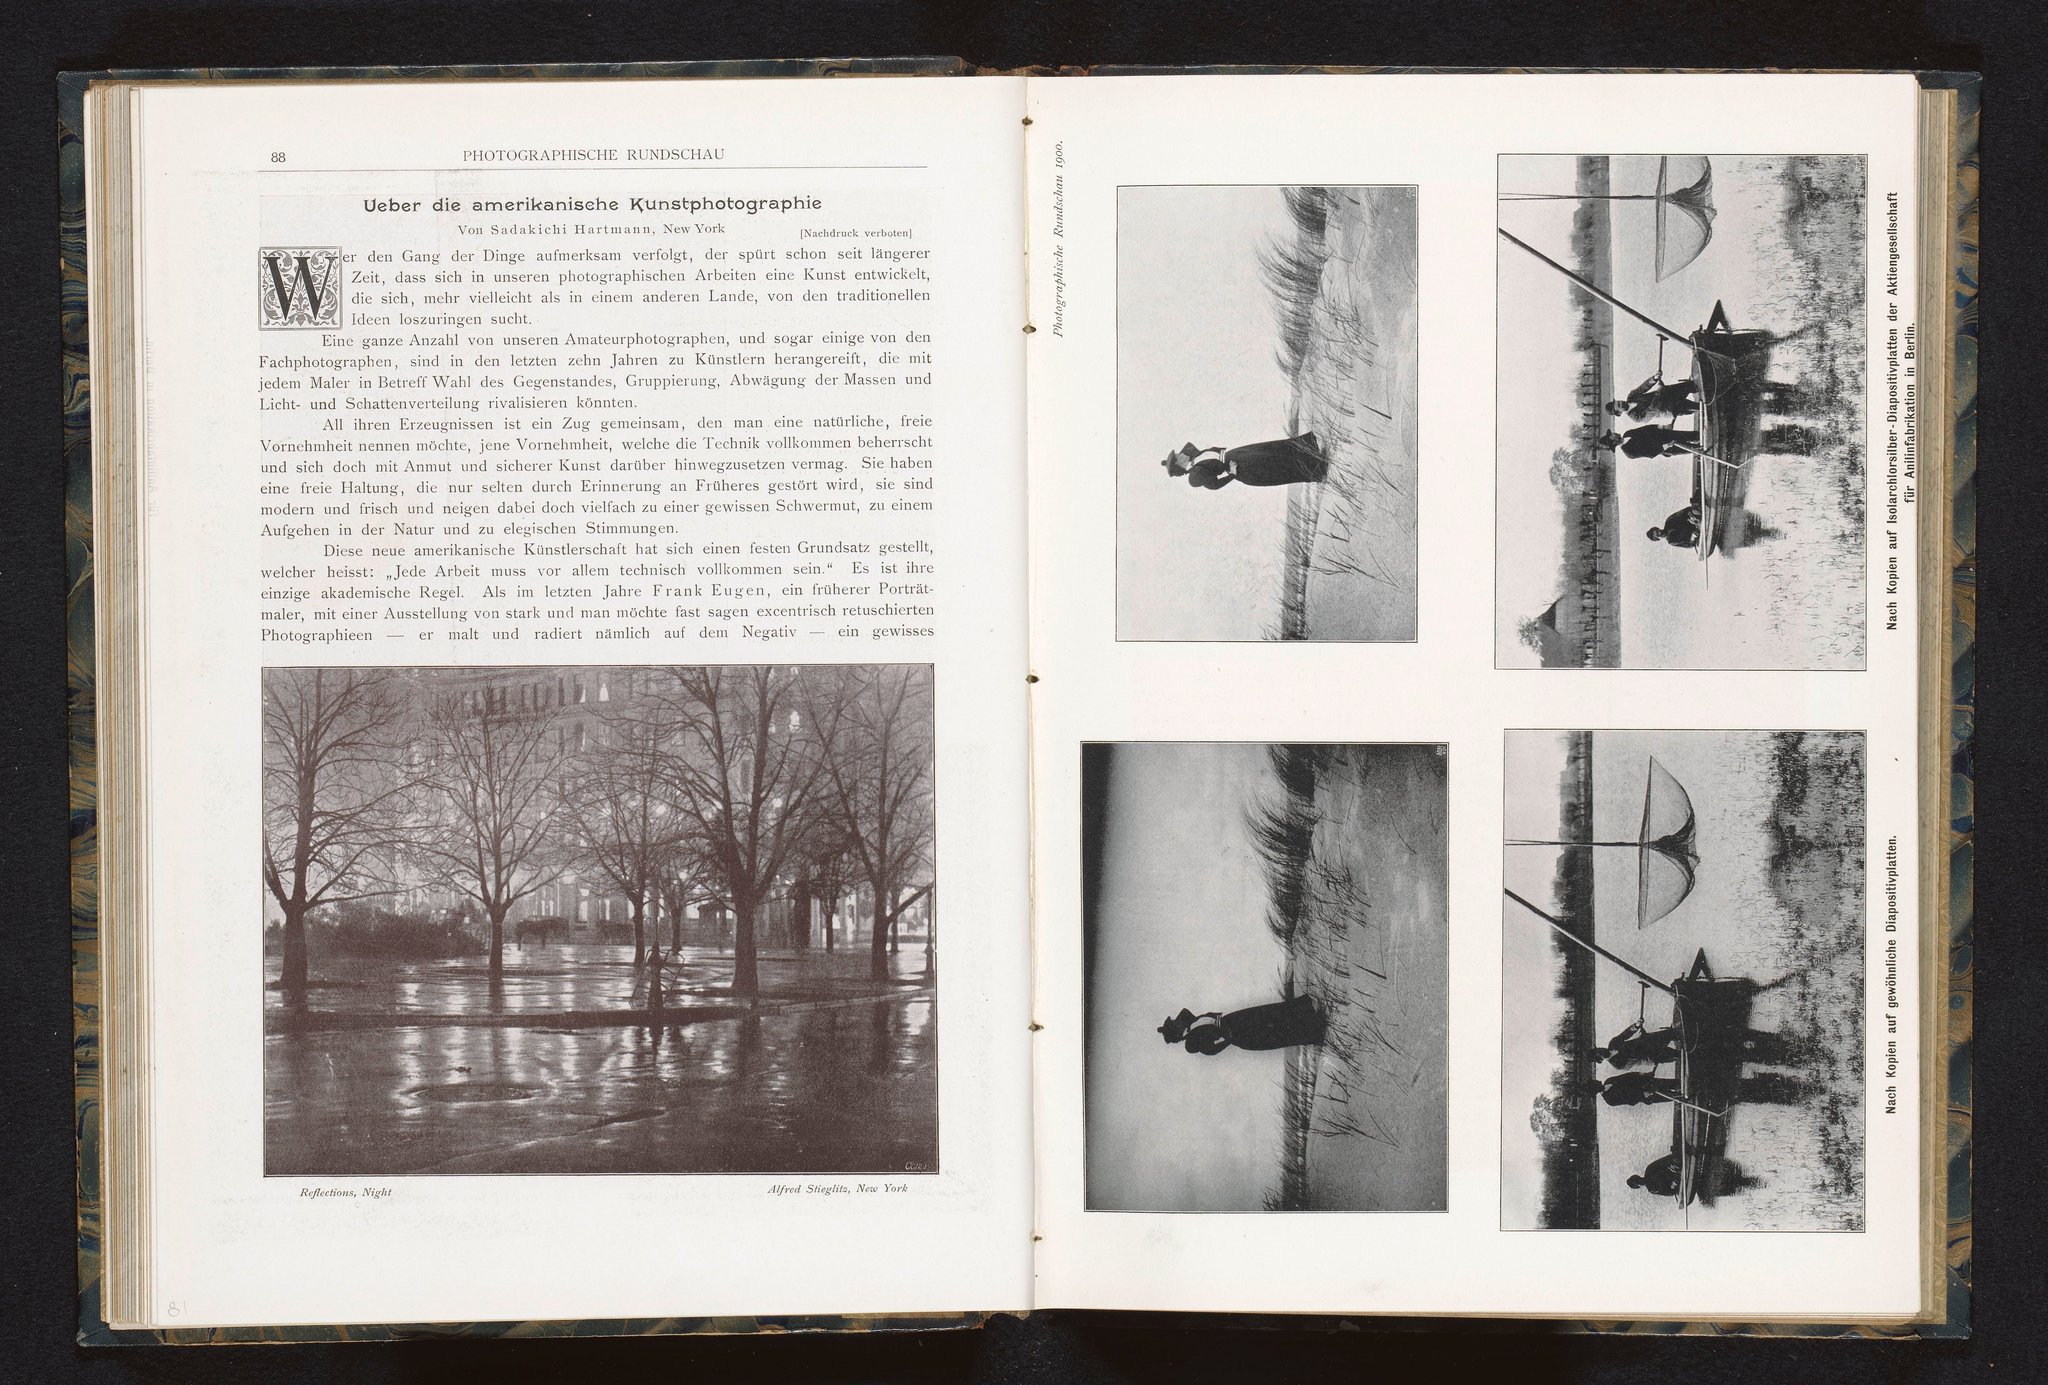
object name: page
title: Twee variaties van twee foto's, één van een onbekende vrouw in de duinen en één van onbekende mannen op een vissersboot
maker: Anonymous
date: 1895-1900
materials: paper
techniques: autotype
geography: berlin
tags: dunes (sea not visible); in the dunes, rowing-boat, canoe, etc.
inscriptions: inscription: ‘Nach Kopien auf gewöhnliche Diapositivplatten. Nach Kopien auf Isolarchlorsilber-Diapositivplatten der Aktiengesellschaft/ für Anilinfabrikation in Berlin.’